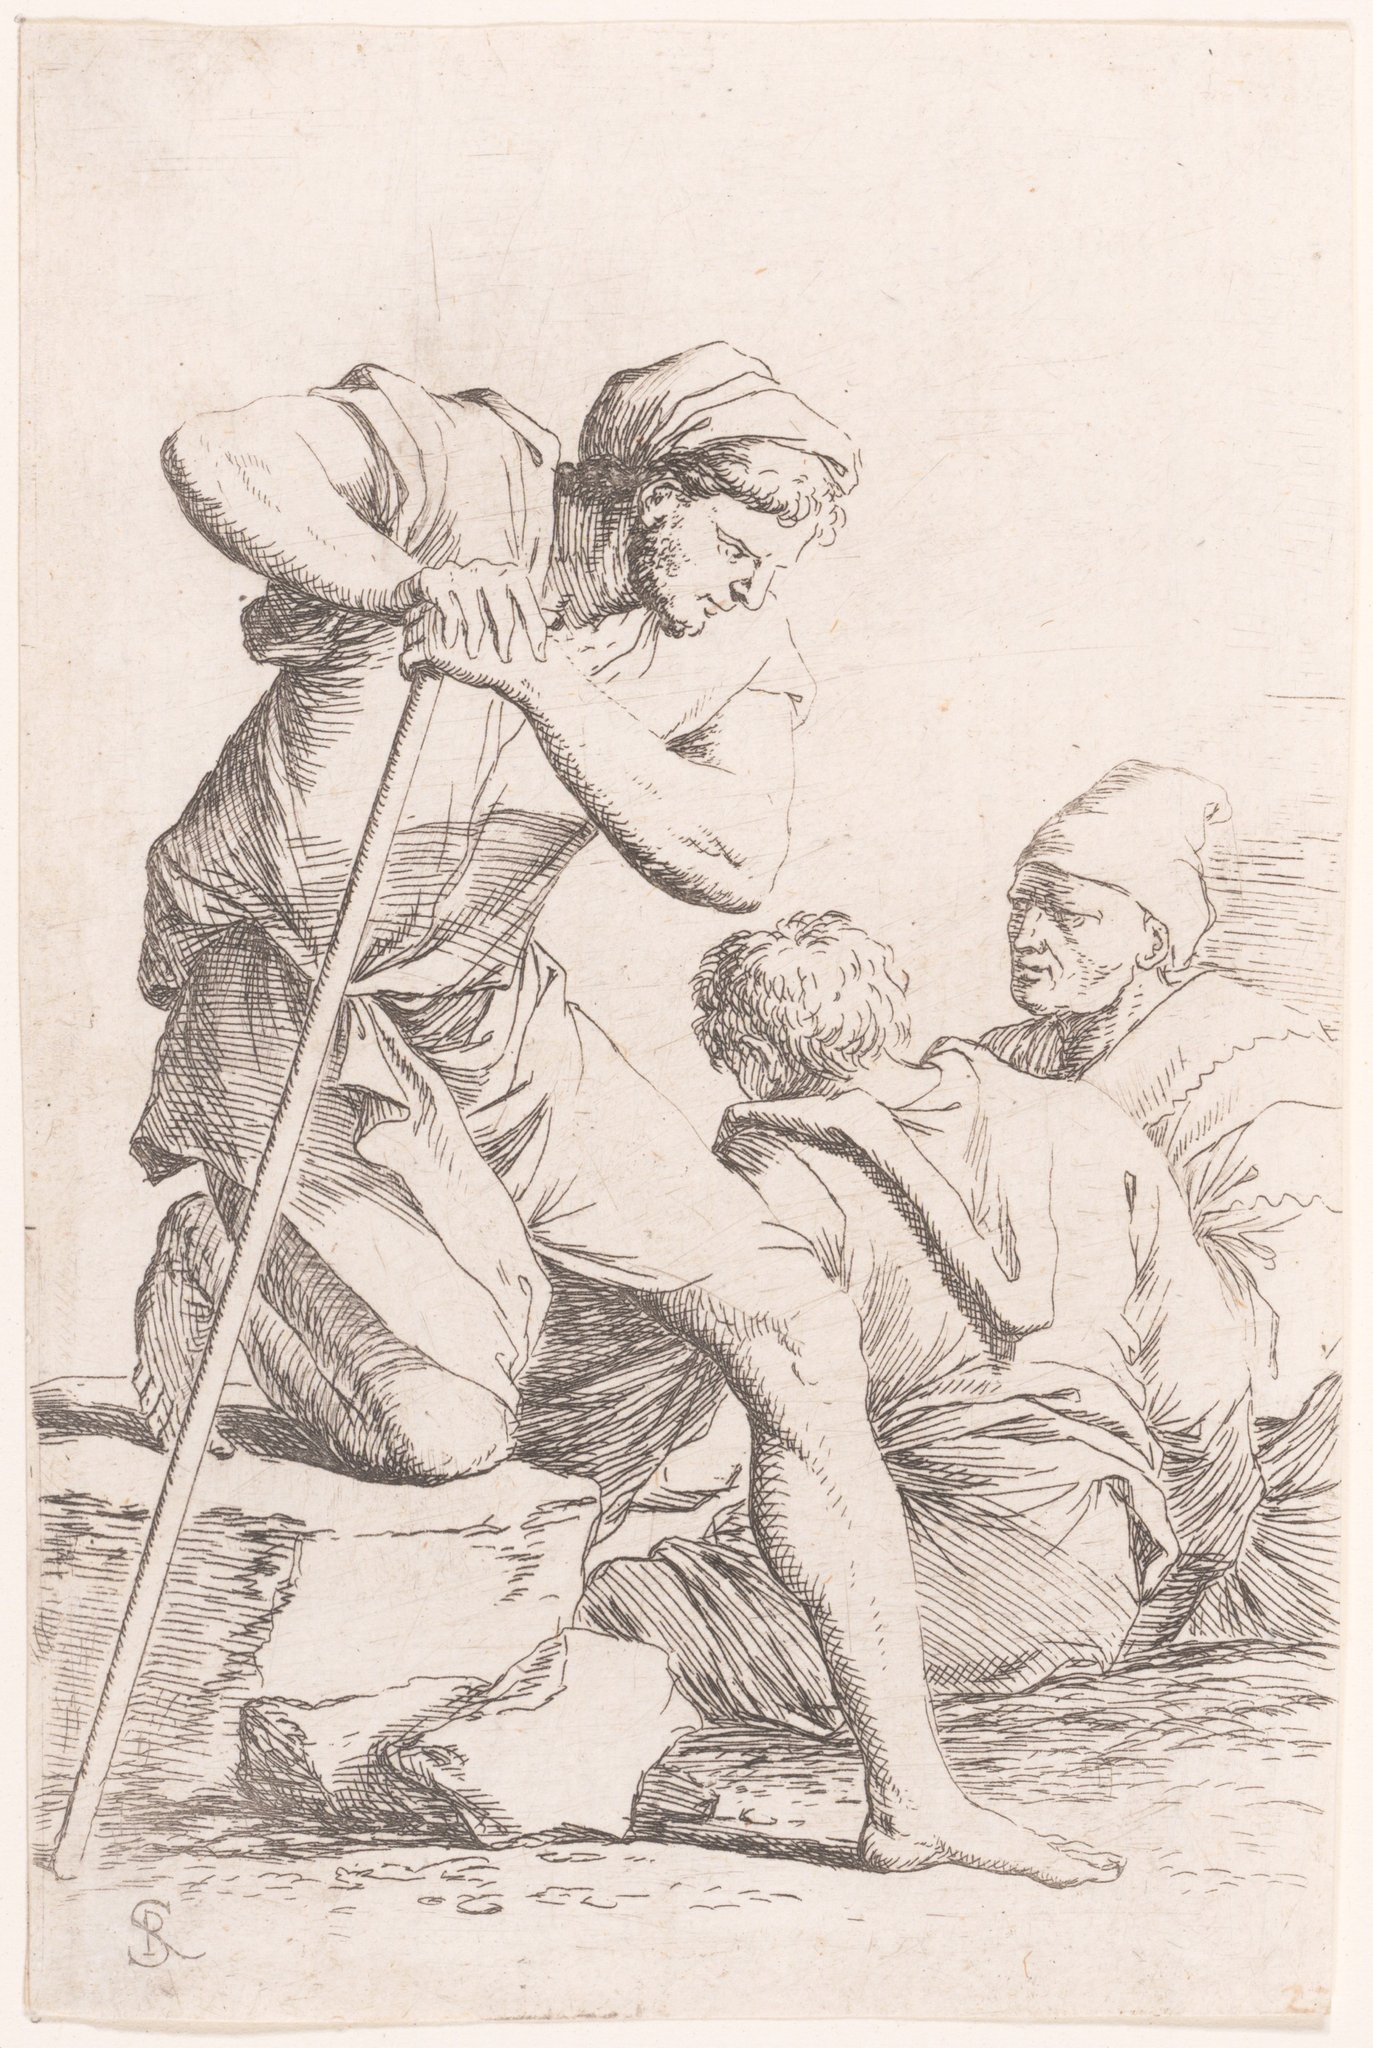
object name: print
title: Two men sitting and another man holding a staff kneeling on a rock, from "Figurine"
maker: salvator rosa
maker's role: artist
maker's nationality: italian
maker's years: 1615-1673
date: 1656-1657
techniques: etching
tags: weapons,men